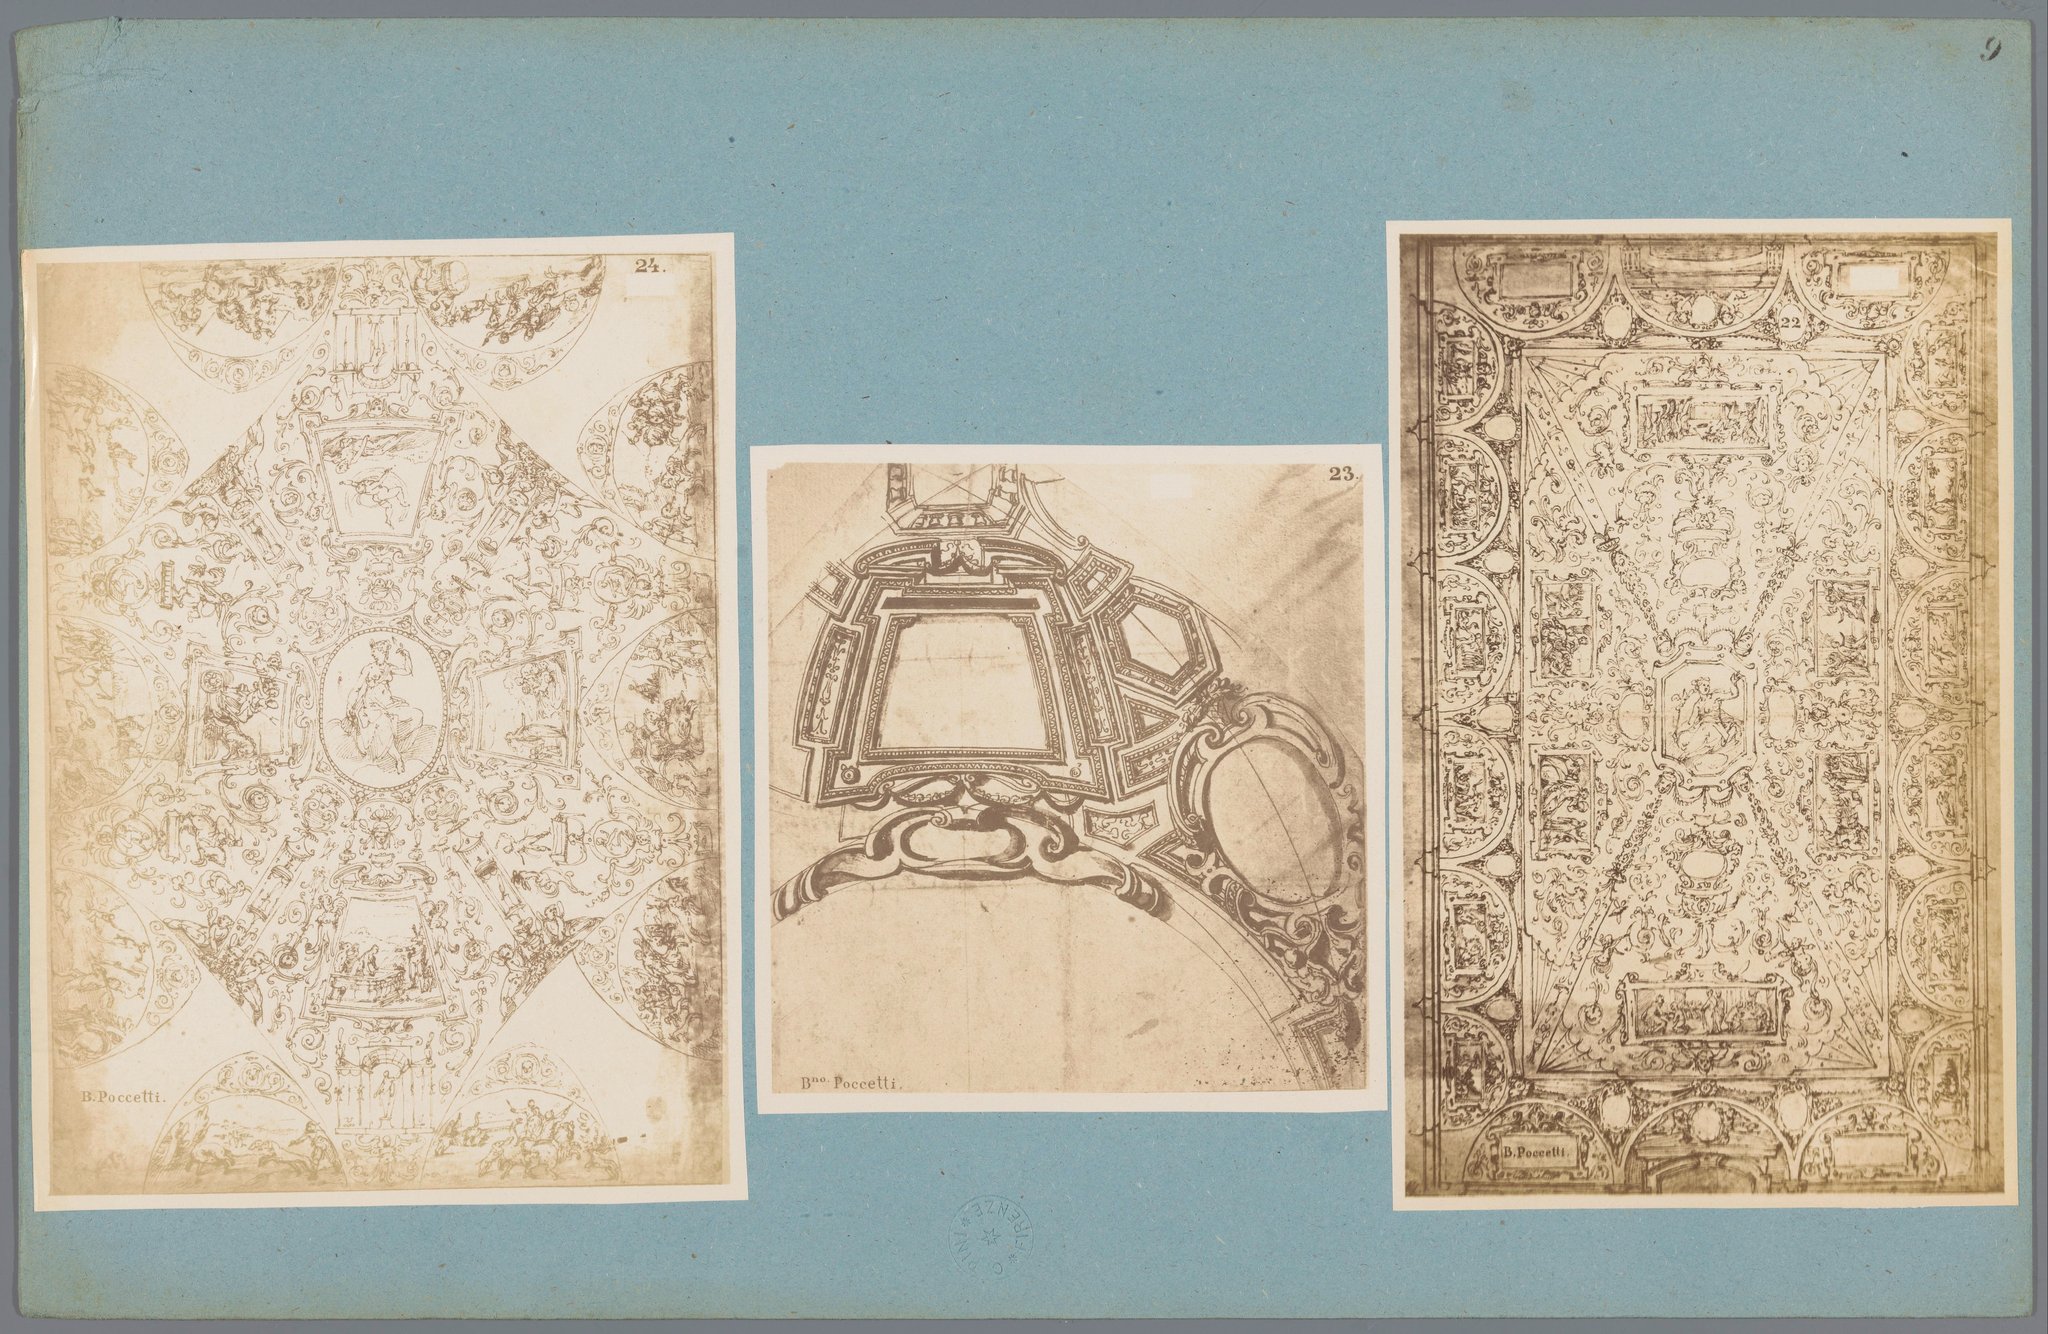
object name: photograph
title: Drie fotoreproducties van tekeningen van plafonddecoraties door Bernardino Poccetti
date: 1875-1900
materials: cardboard, photographic support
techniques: albumen print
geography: europe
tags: drawing, sketch, (decorated) ceiling, europe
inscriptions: number: ‘24.’, name: ‘C. Pini Firenze’, number: ‘9’, number: ‘23.’, collector's mark: Lugt 3937, number: ‘22’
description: Links (24) en rechts (22) een plafondschildering met centraal een vrouw met een staf, midden (23) een detail van een boog met cassettes.